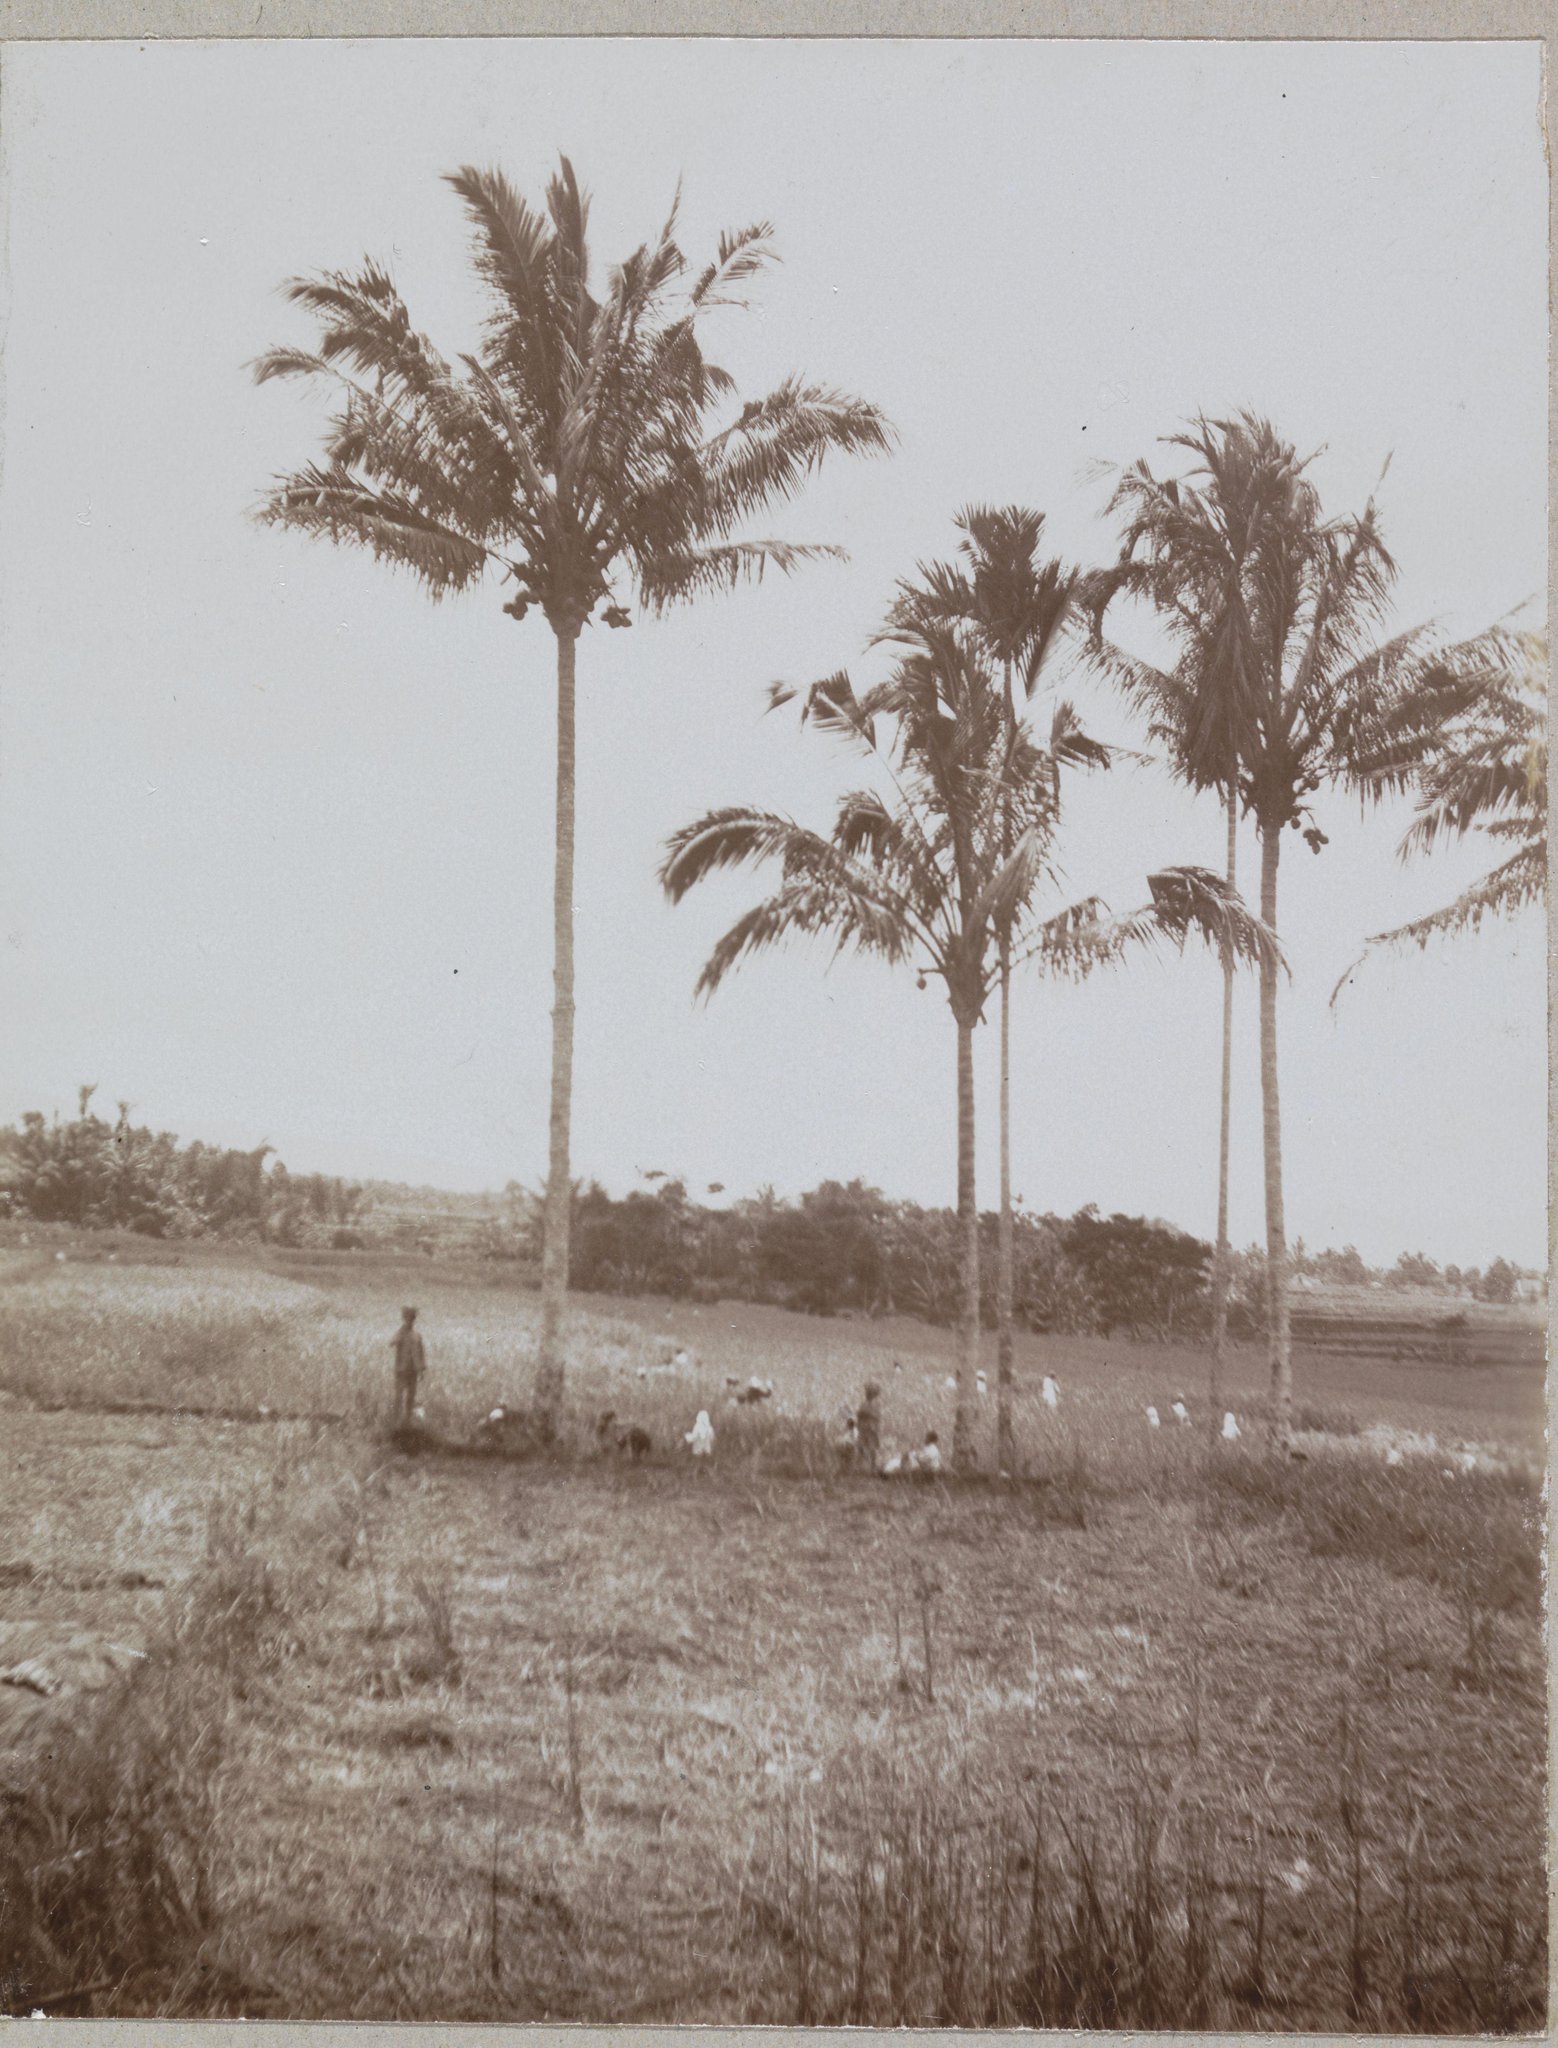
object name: photograph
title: Afgesneden paddiveld, Nederlands-Indië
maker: Anonymous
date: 1895-1915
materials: cardboard, paper, photographic support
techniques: collodion silver print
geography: dutch east indies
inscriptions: annotation: ‘3) afgesneden paddiveld’